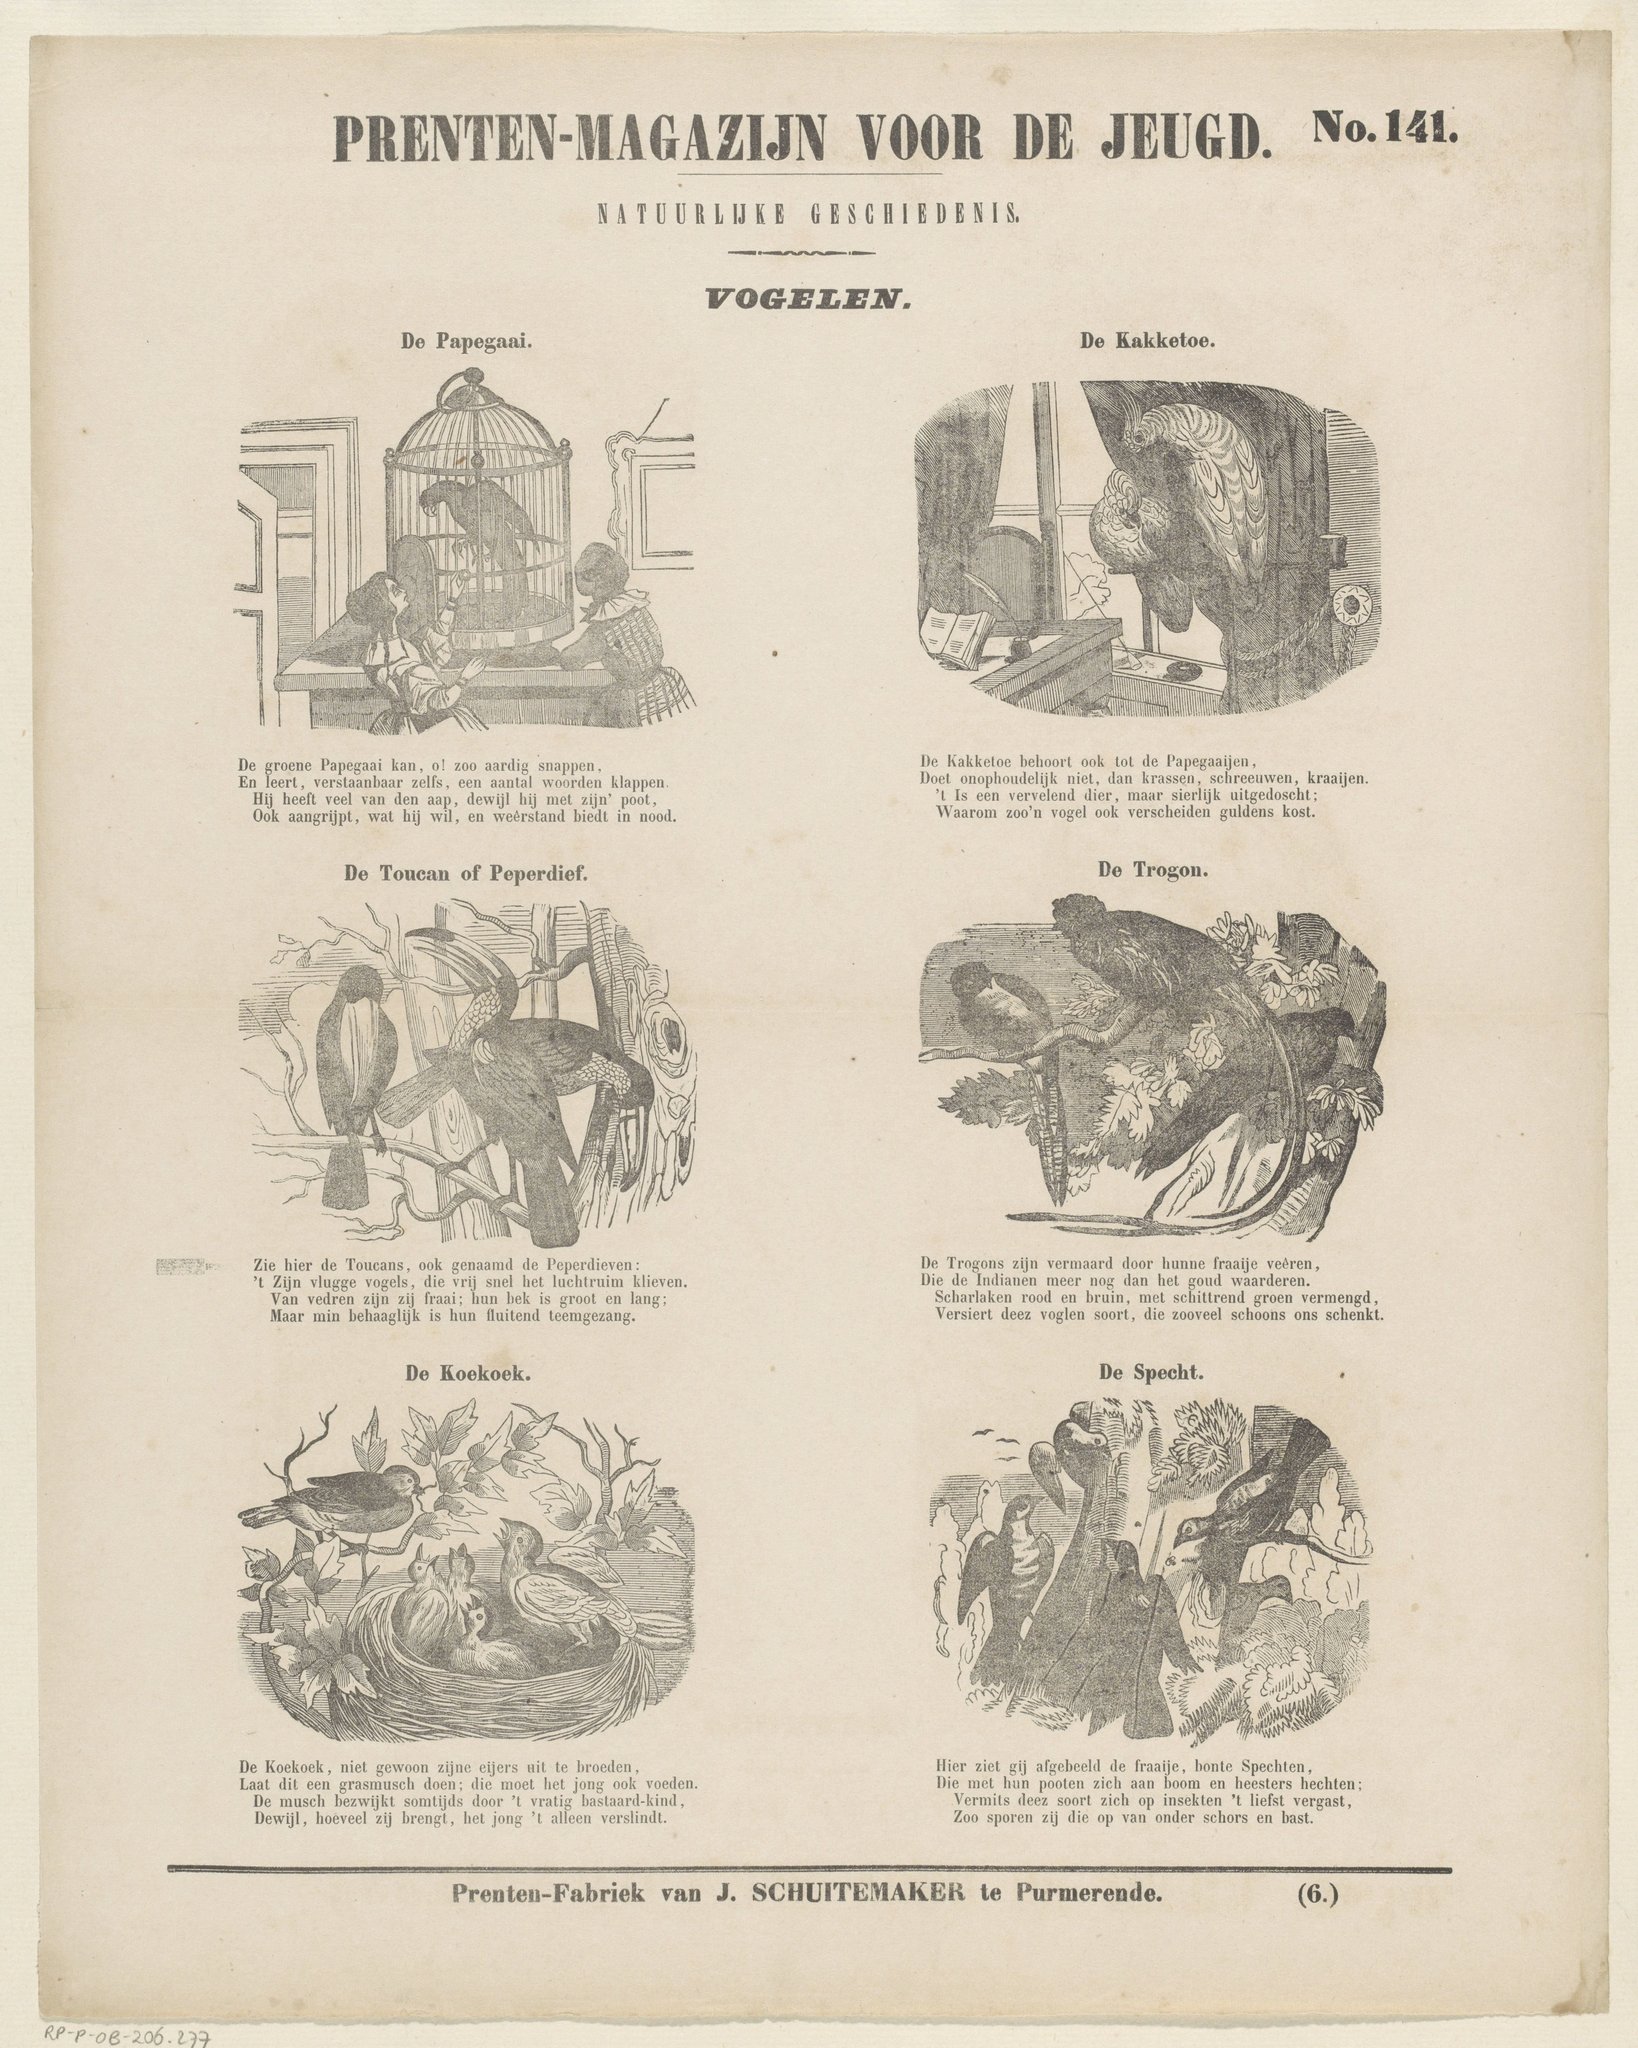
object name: popular print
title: Vogelen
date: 1850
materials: paper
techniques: letterpress printing, engraving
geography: netherlands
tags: other birds: cuckoo, birds, other birds: woodpecker, ornamental birds: parrot, ornamental birds: cockatoo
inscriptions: collector's mark: Lugt 2760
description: Na voltooiing van de acht jaargangen van de reeks 'Prenten-magazijn voor de jeugd' in 1850 heeft Jan Schuitemaker al deze prenten heruitgegeven en omgenummerd als nr. 1 t/m 192. De oorspronkelijke jaargang wordt telkens nog vermeld rechtsonder op de prent. Binnen de jaargangen zijn prenten van hetzelfde thema in clusters van vier achter elkaar gezet.